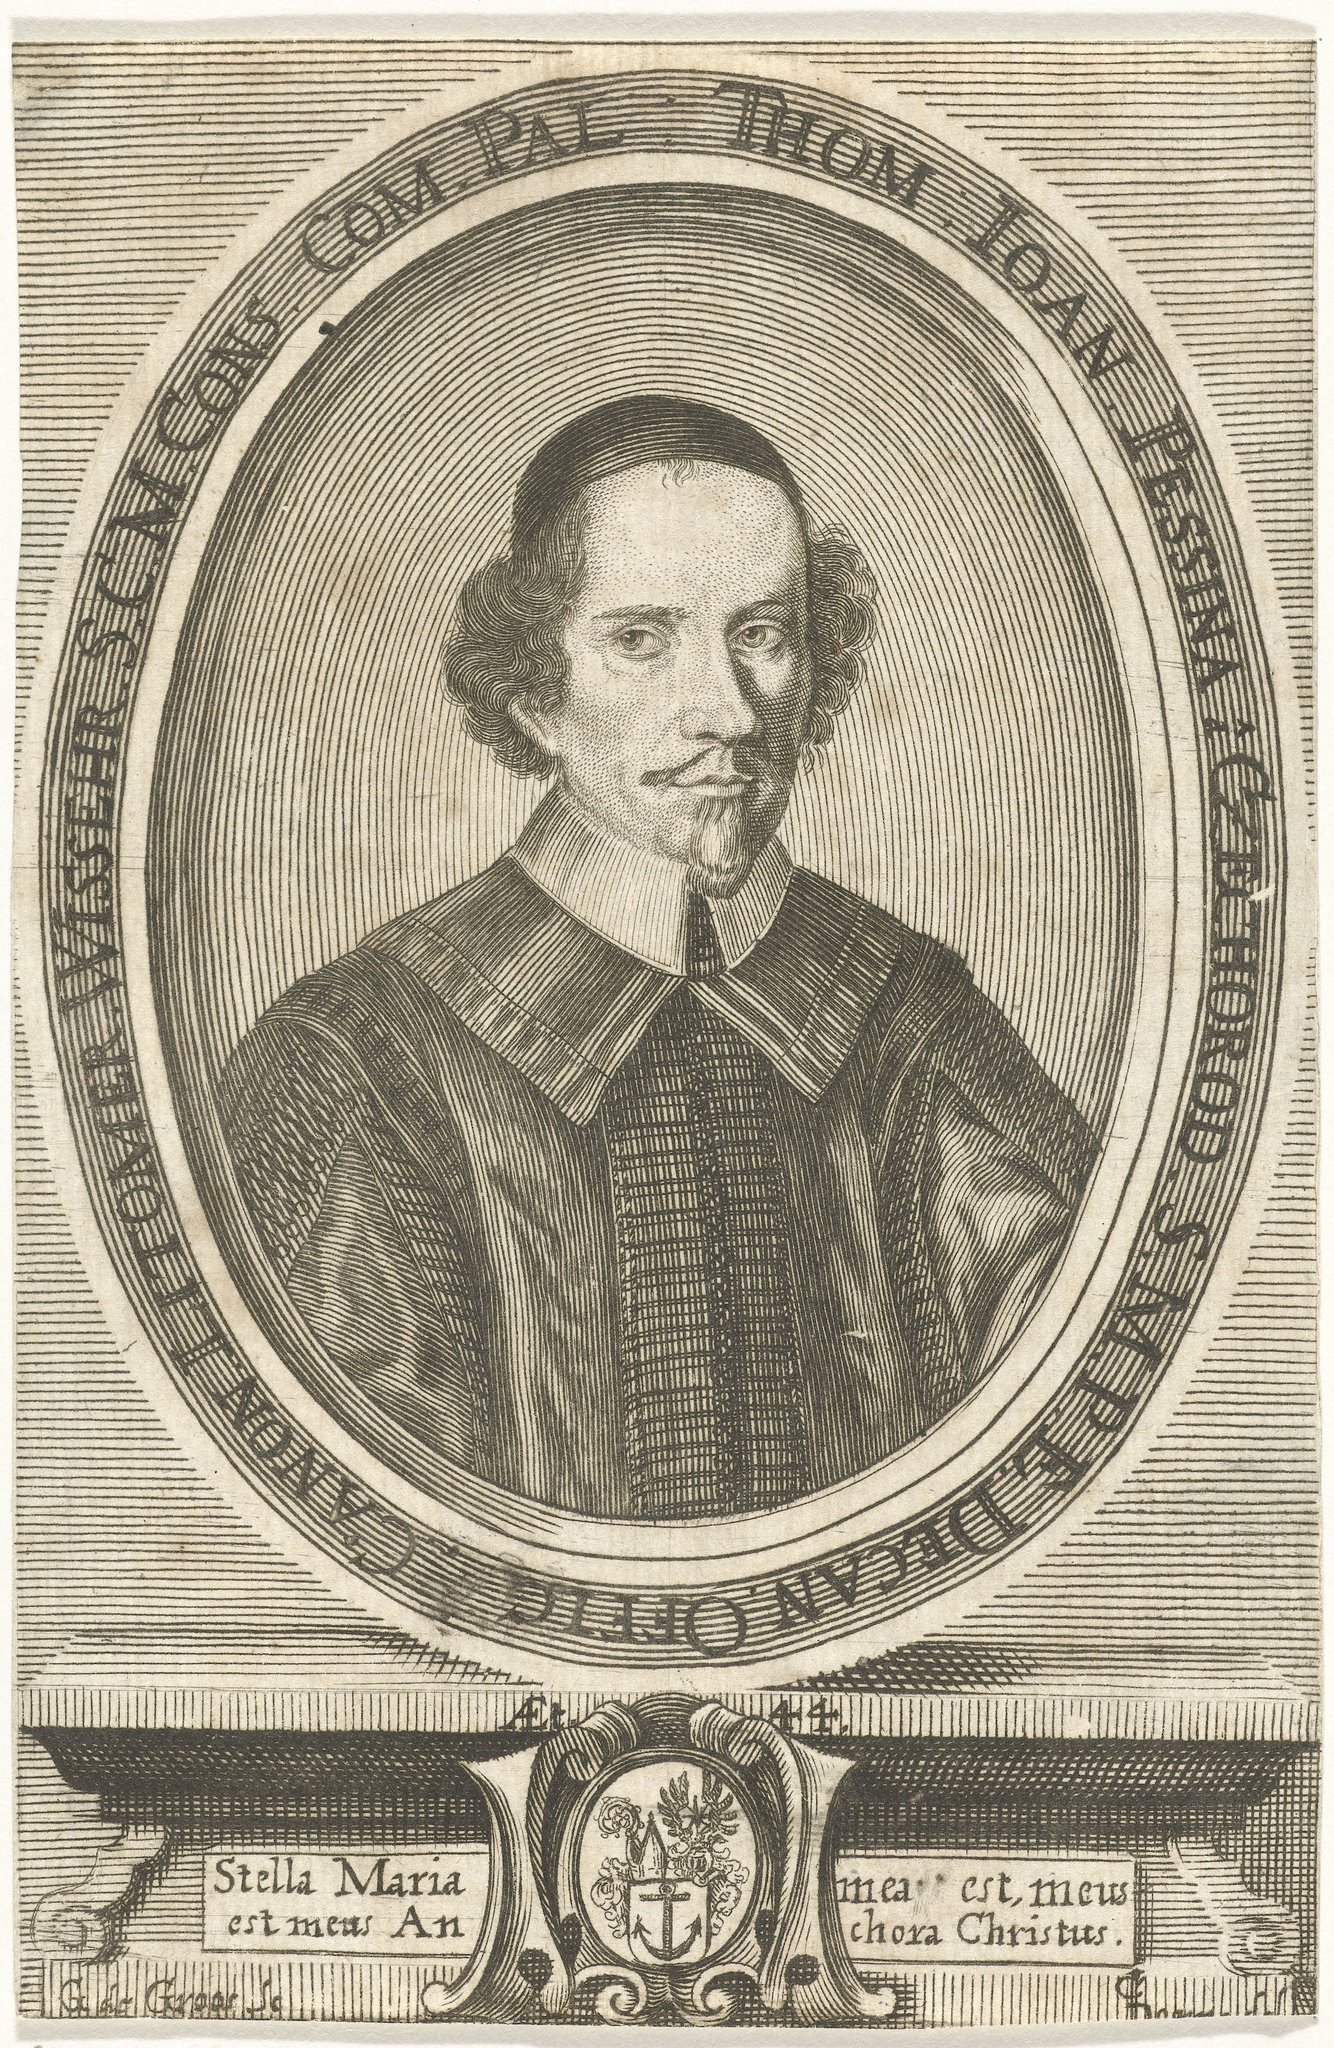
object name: print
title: Portret van Thomas Joannes Pessina de Czechorod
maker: gerard de groos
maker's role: print maker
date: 1660-1730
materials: paper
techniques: engraving, etching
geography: prague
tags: theoloog, thomas joannes pessina de czechorod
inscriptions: collector's mark: Lugt 2228, collector's mark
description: Portret van Thomas Joannes Pessina de Czechorod, met kalot. Het portret is gevat in een ovale omlijsting met een randschrift in het Latijn. Op het piëdestal een wapenschild, met daarboven zijn leeftijd, en in het kader twee regels in het Latijn.